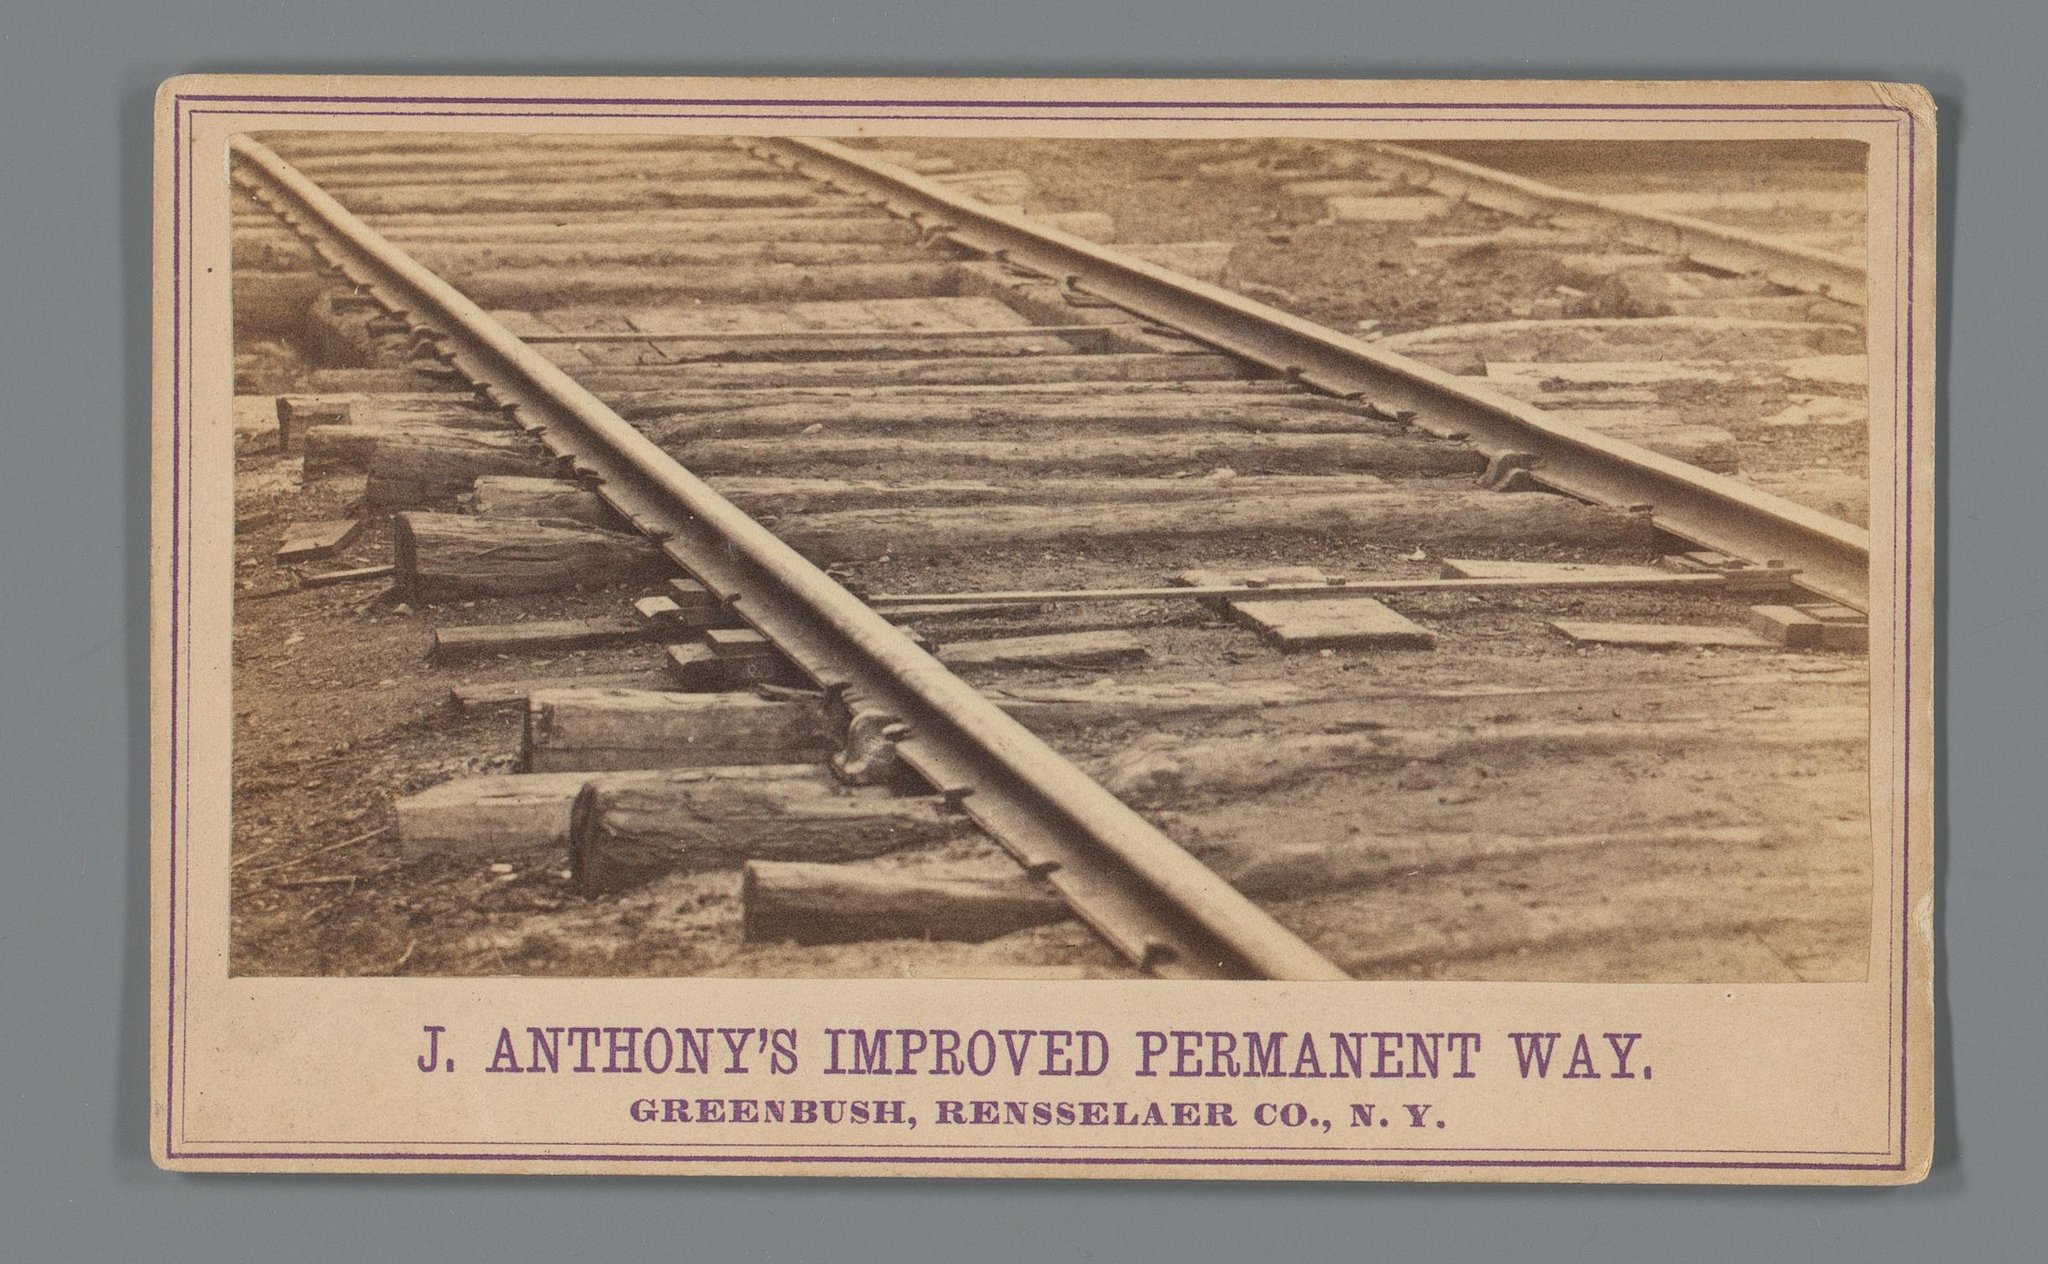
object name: photograph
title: Treinrails als reclame voor J. Anthony's Improved Permanent Way in het voormalige Greenbush in Rensselaer County, New York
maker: Anonymous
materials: cardboard, photographic support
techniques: albumen print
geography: united states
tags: railway, tramway; rack railway, united states of america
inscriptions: date and inscription: ‘oct 16. 1864/ ocab72/ +35’, postage stamp: ‘C&O/ Oct 6/ 1864’